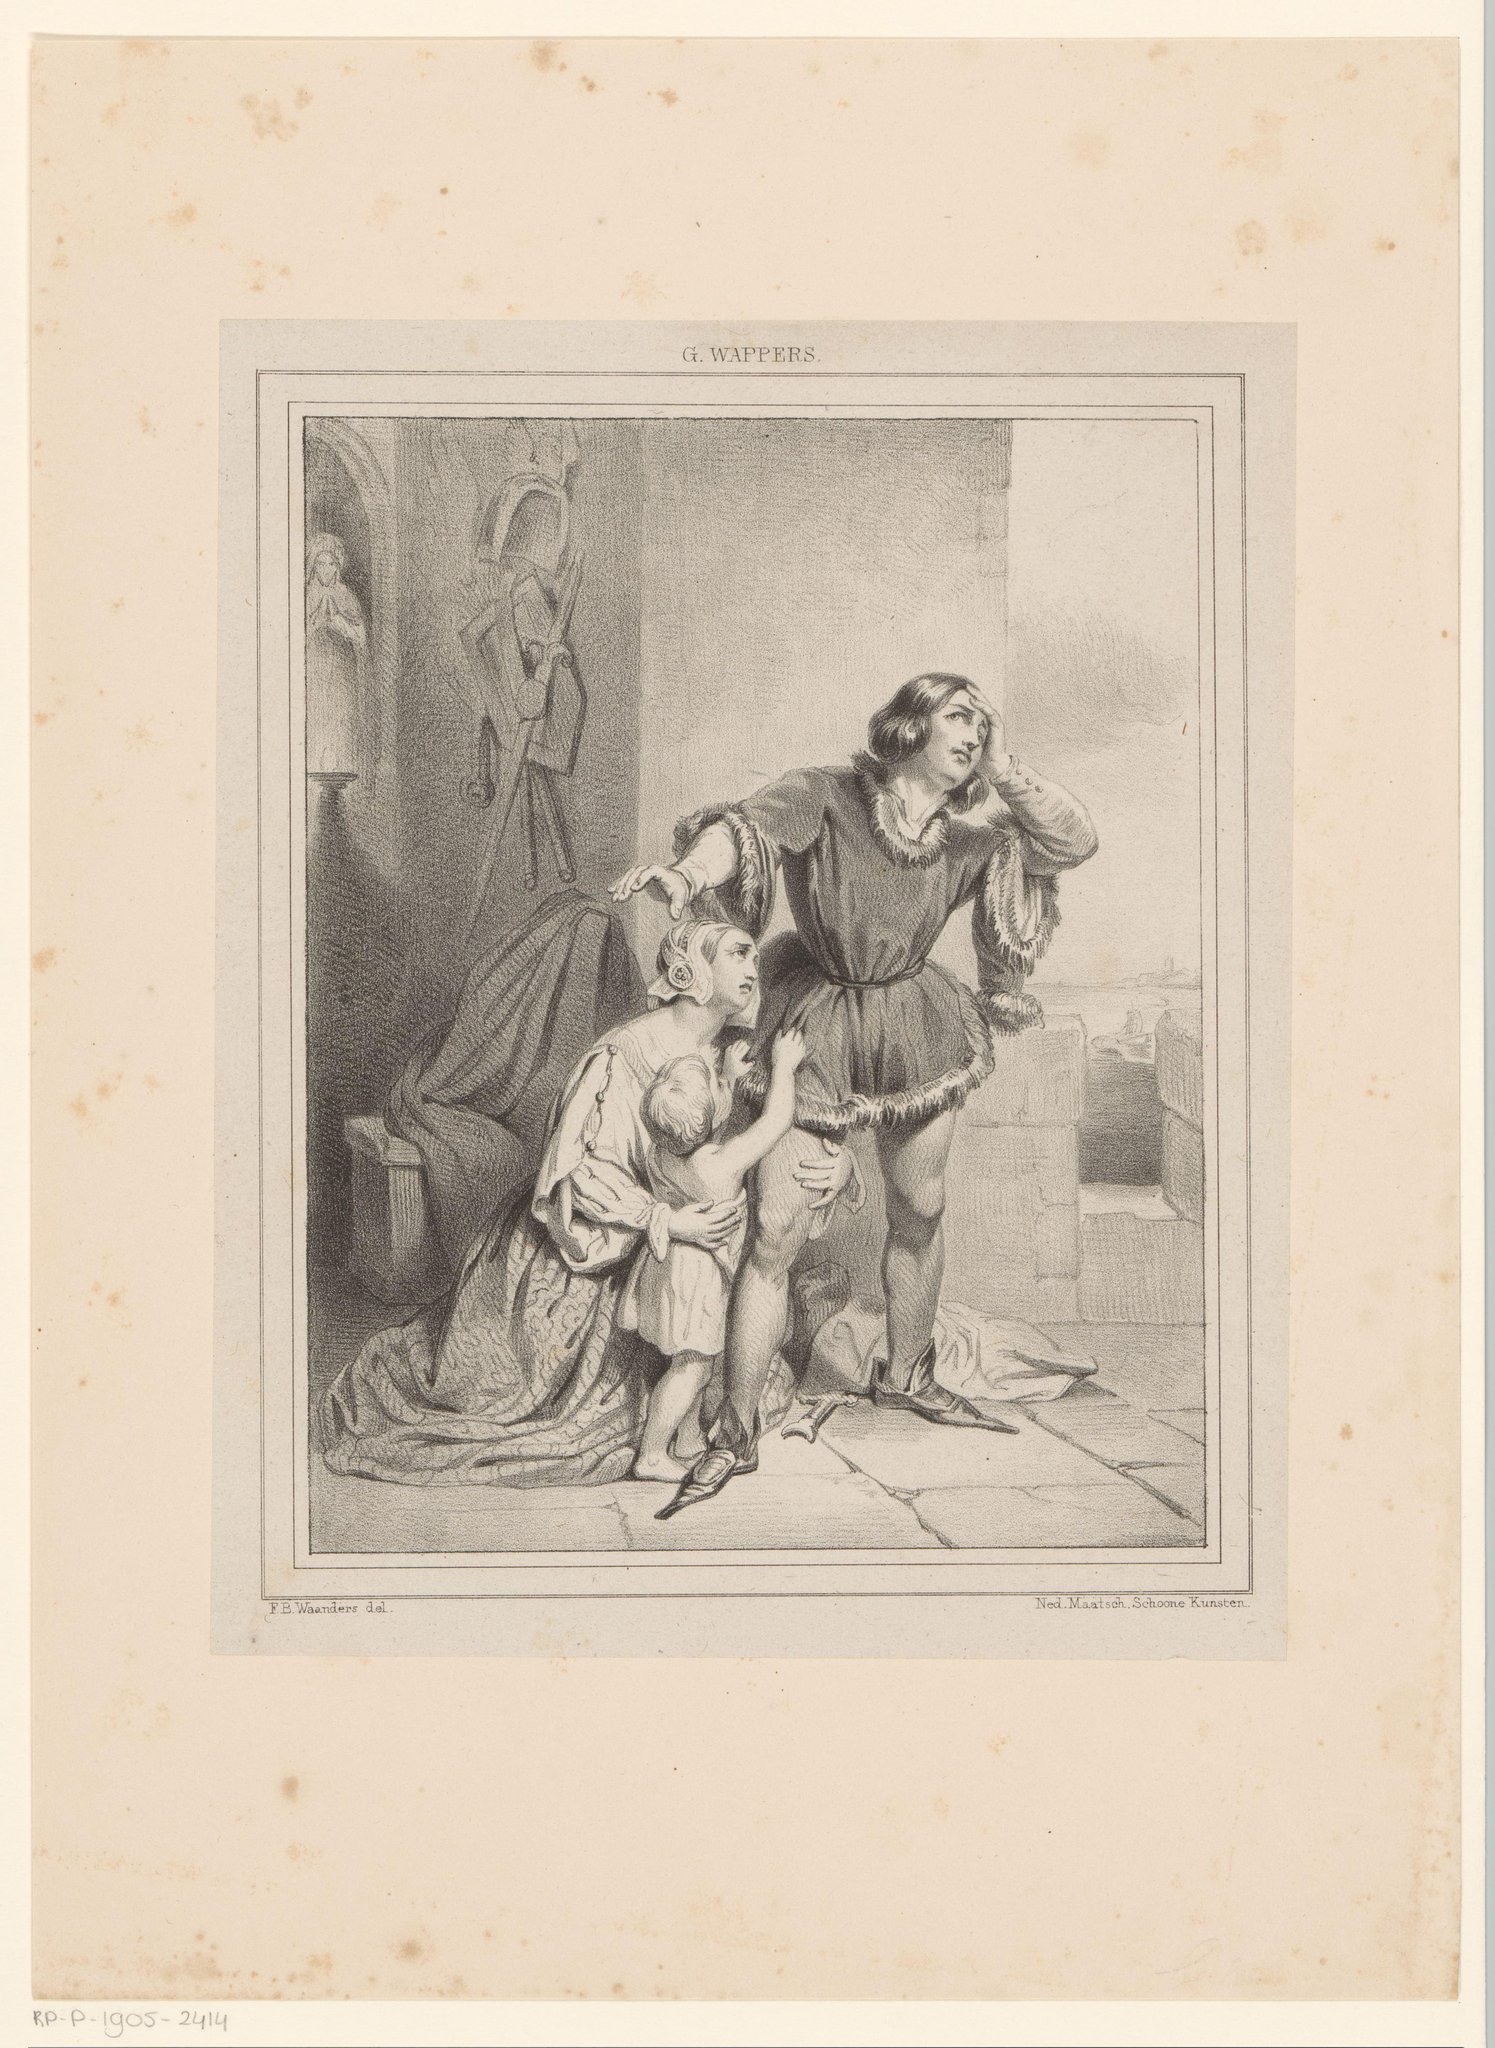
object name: print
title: Albrecht Beiling neemt afscheid van vrouw en kind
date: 1840-1841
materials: paper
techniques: lithograph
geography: the hague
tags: self-sacrifice, death in the service of a higher purpose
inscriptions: collector's mark: Lugt 2228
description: Albrecht Beiling neemt afscheid van vrouw en kind, voordat hij in 1425 levend wordt begraven.